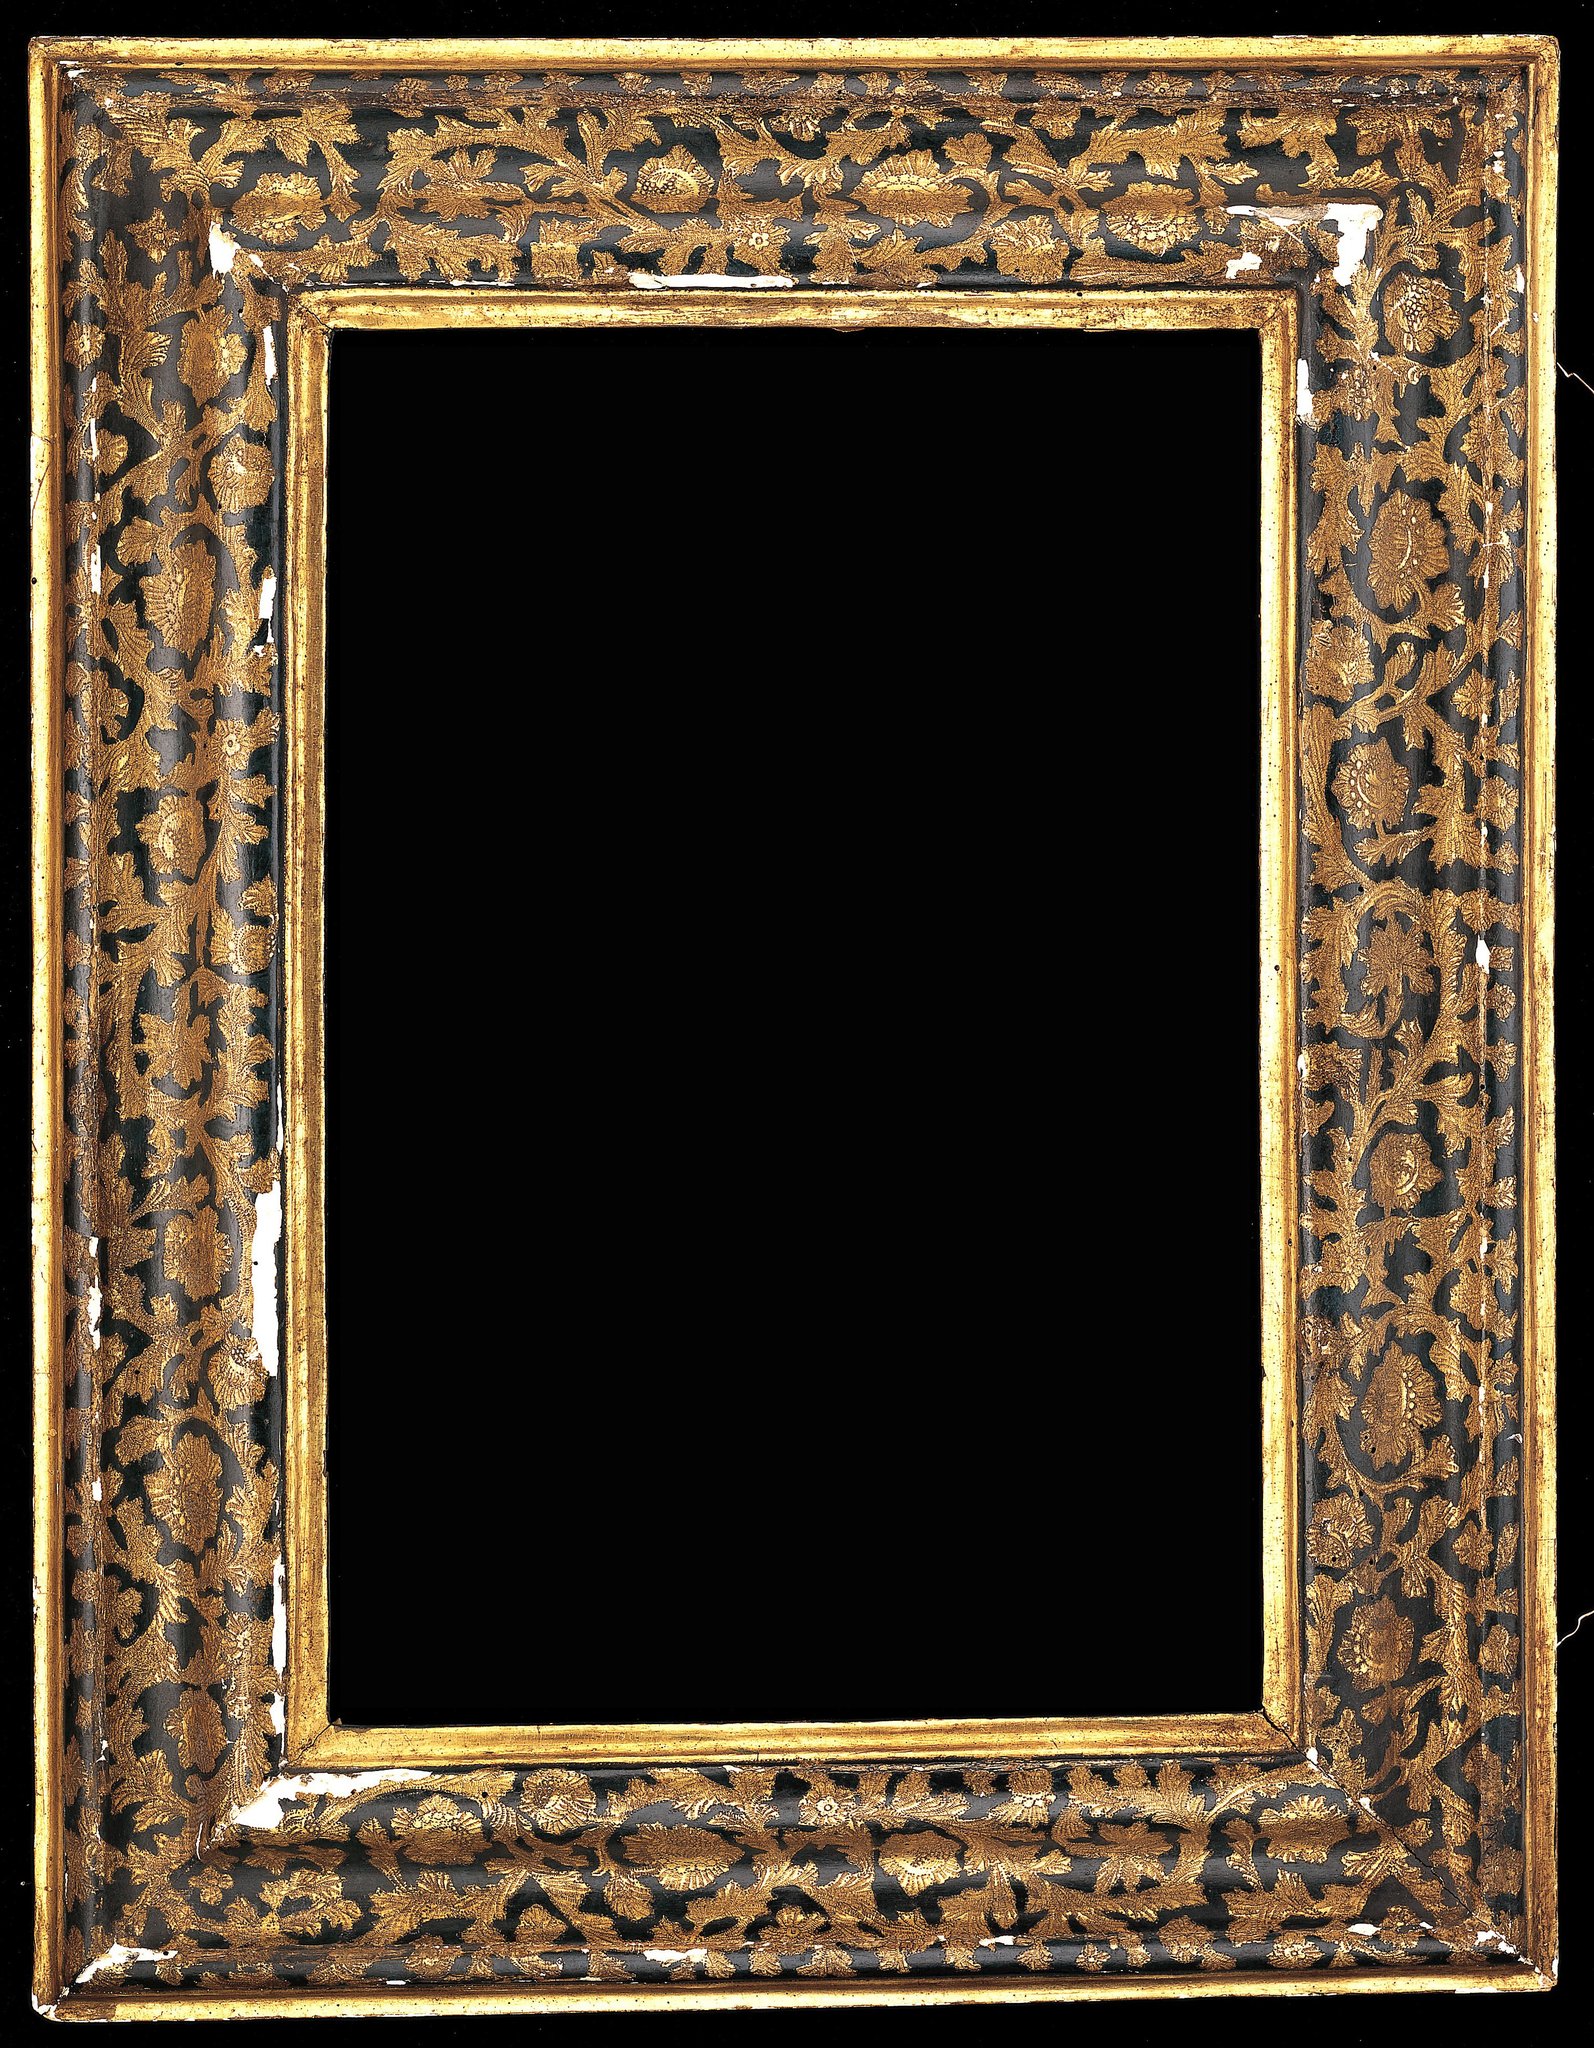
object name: frame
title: Reverse ogee molding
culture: italian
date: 1634-1666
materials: wood